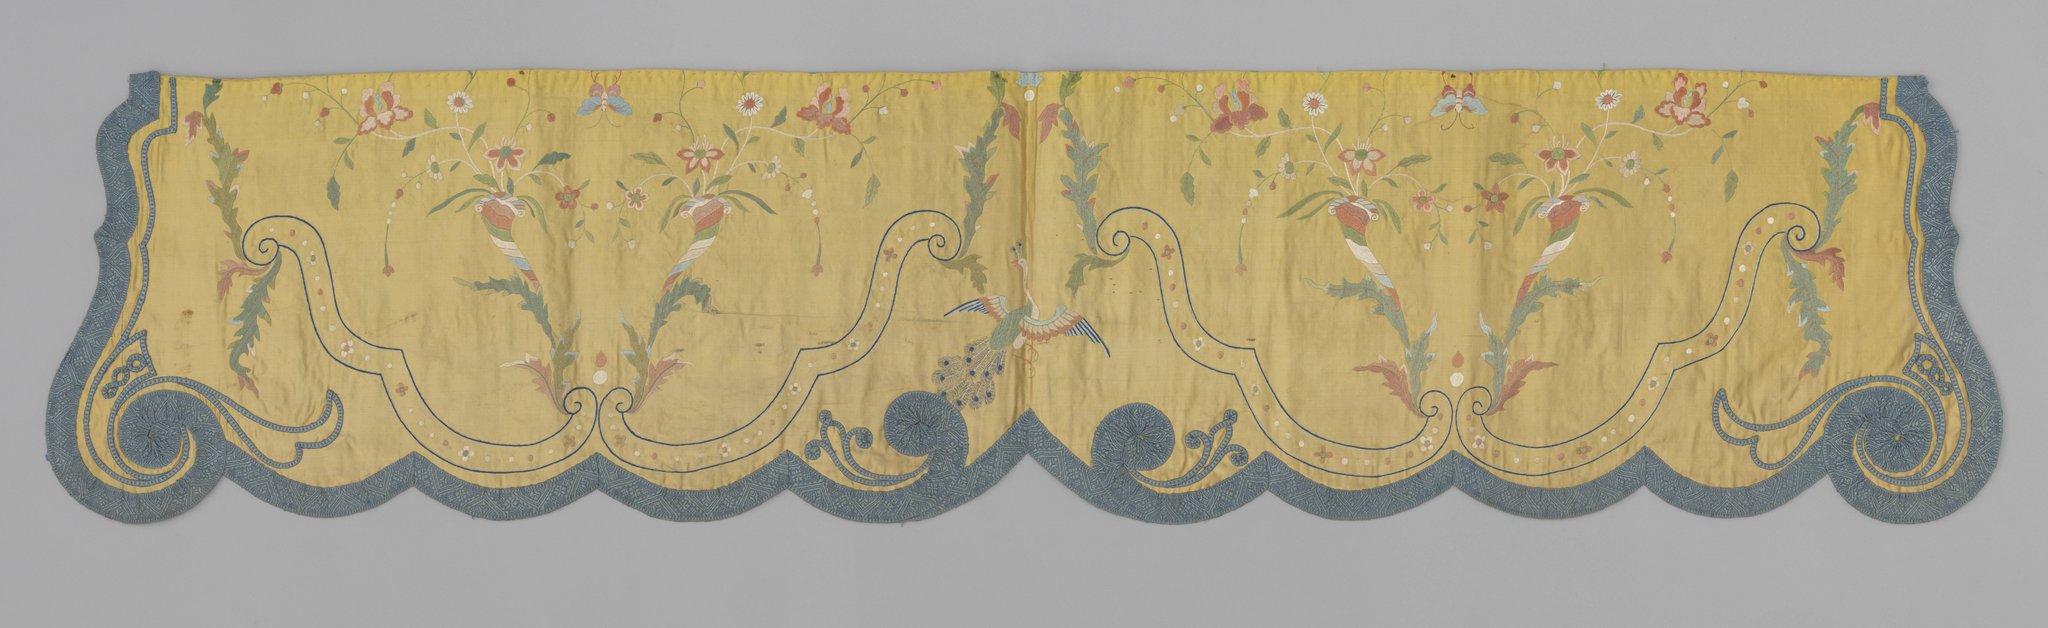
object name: silk textile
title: Matrasomhang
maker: Anonymous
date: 1720-1740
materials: linen, silk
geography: guangdong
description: Geel zijden matrasomhang van een bedgarnituur geborduurd met pauwen, bloemen, vlinders, hoorns van overvloed in veelkleurige zijde, omboord en versierd met blauw passement, gevoerd met grof linnen. Bestemd voor de voorkant van het bed.